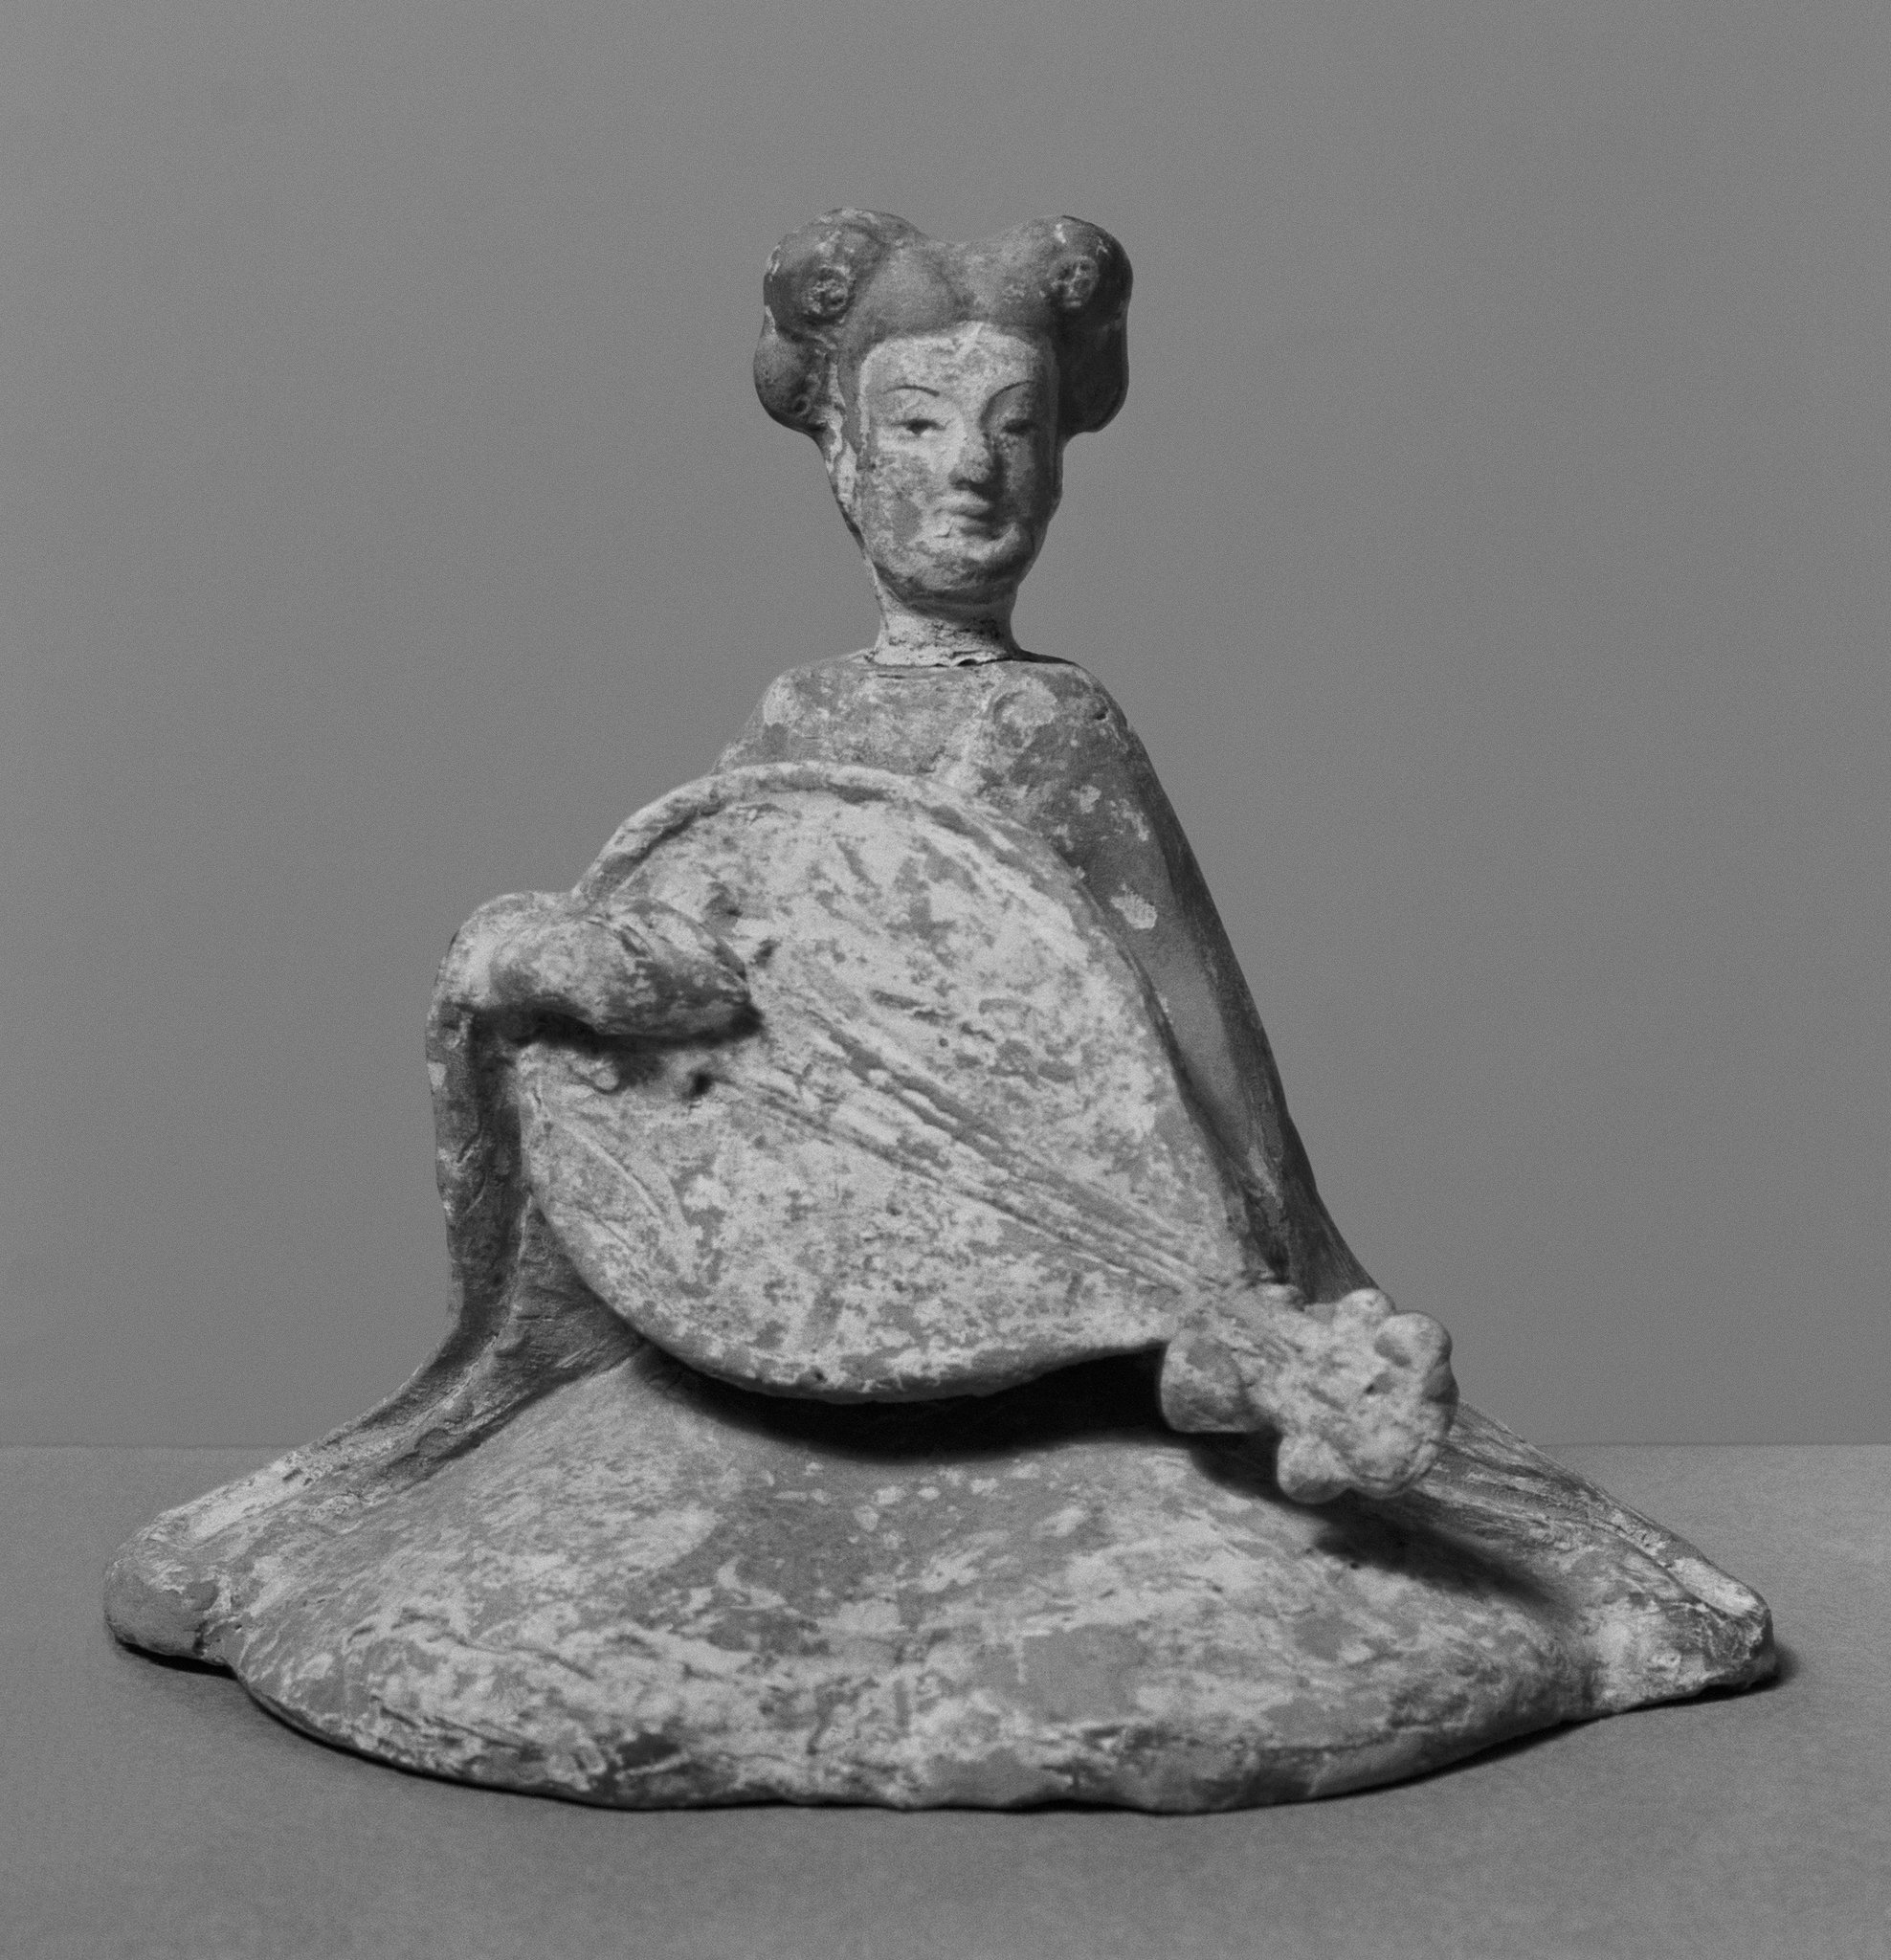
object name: figure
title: Female musician with lute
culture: chinese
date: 501-700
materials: earthenware, pigment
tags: human figures,musical instruments,musicians